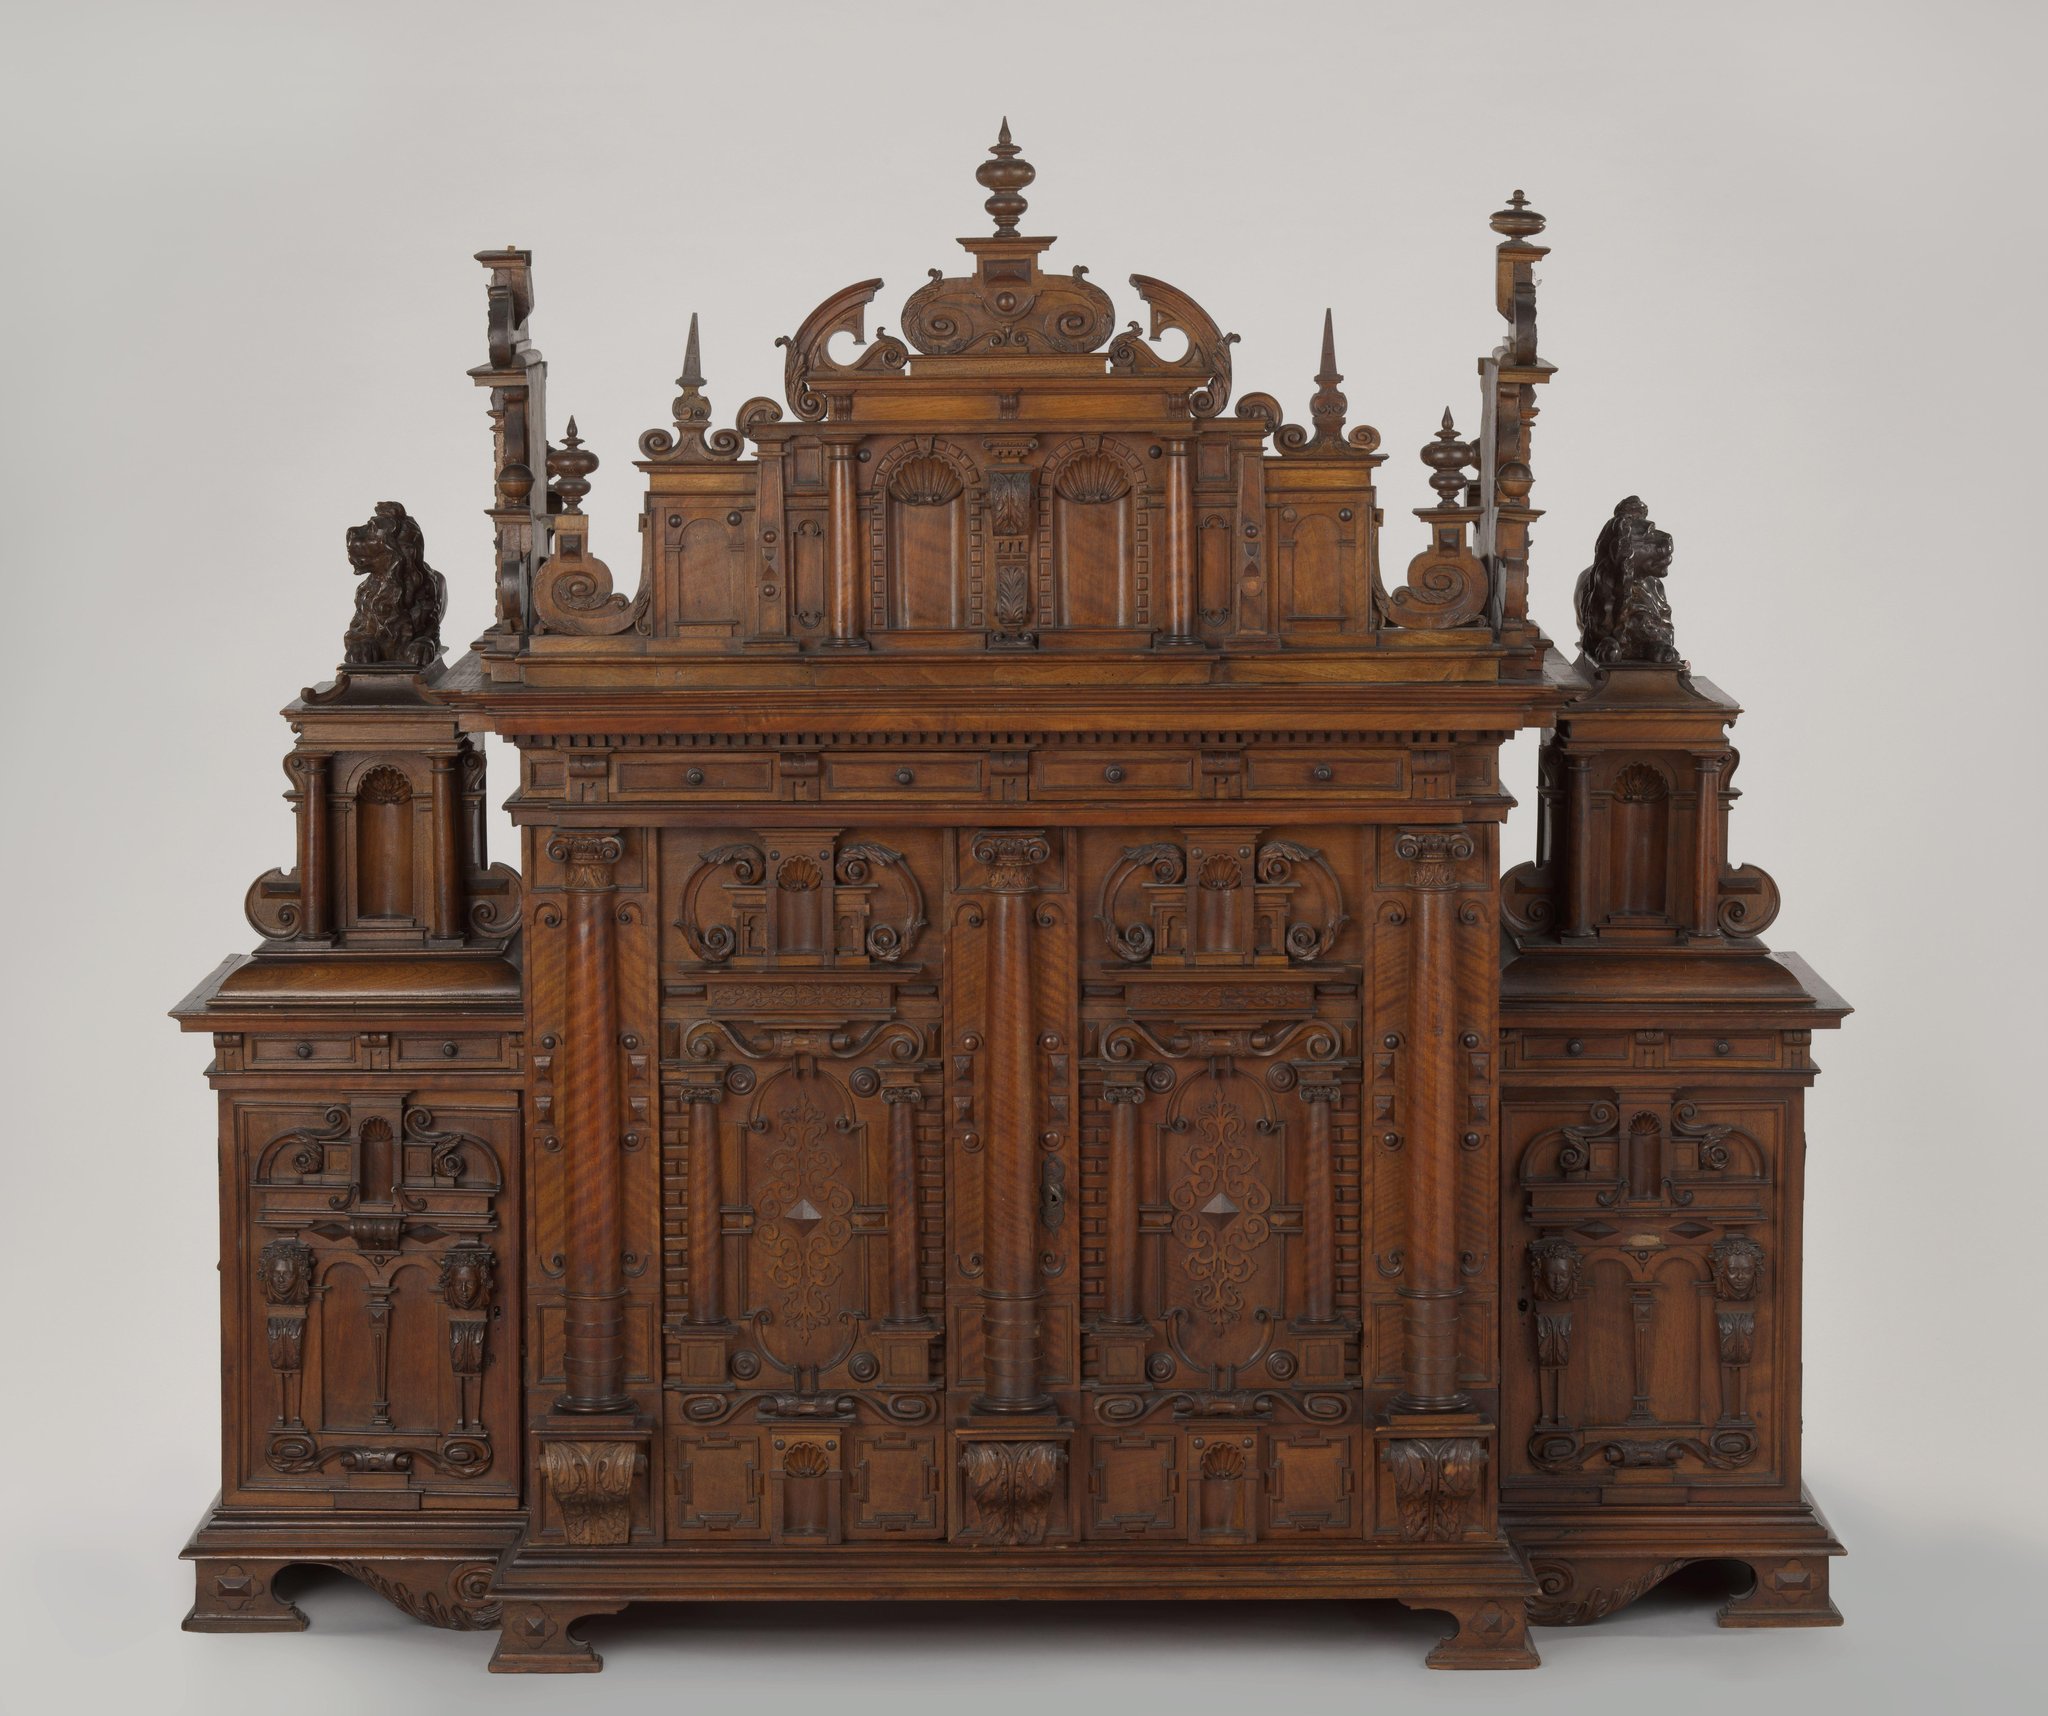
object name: cabinet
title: Kunstkabinet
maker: Anonymous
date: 1800-1899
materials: glass, wood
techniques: veneering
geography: southern germany